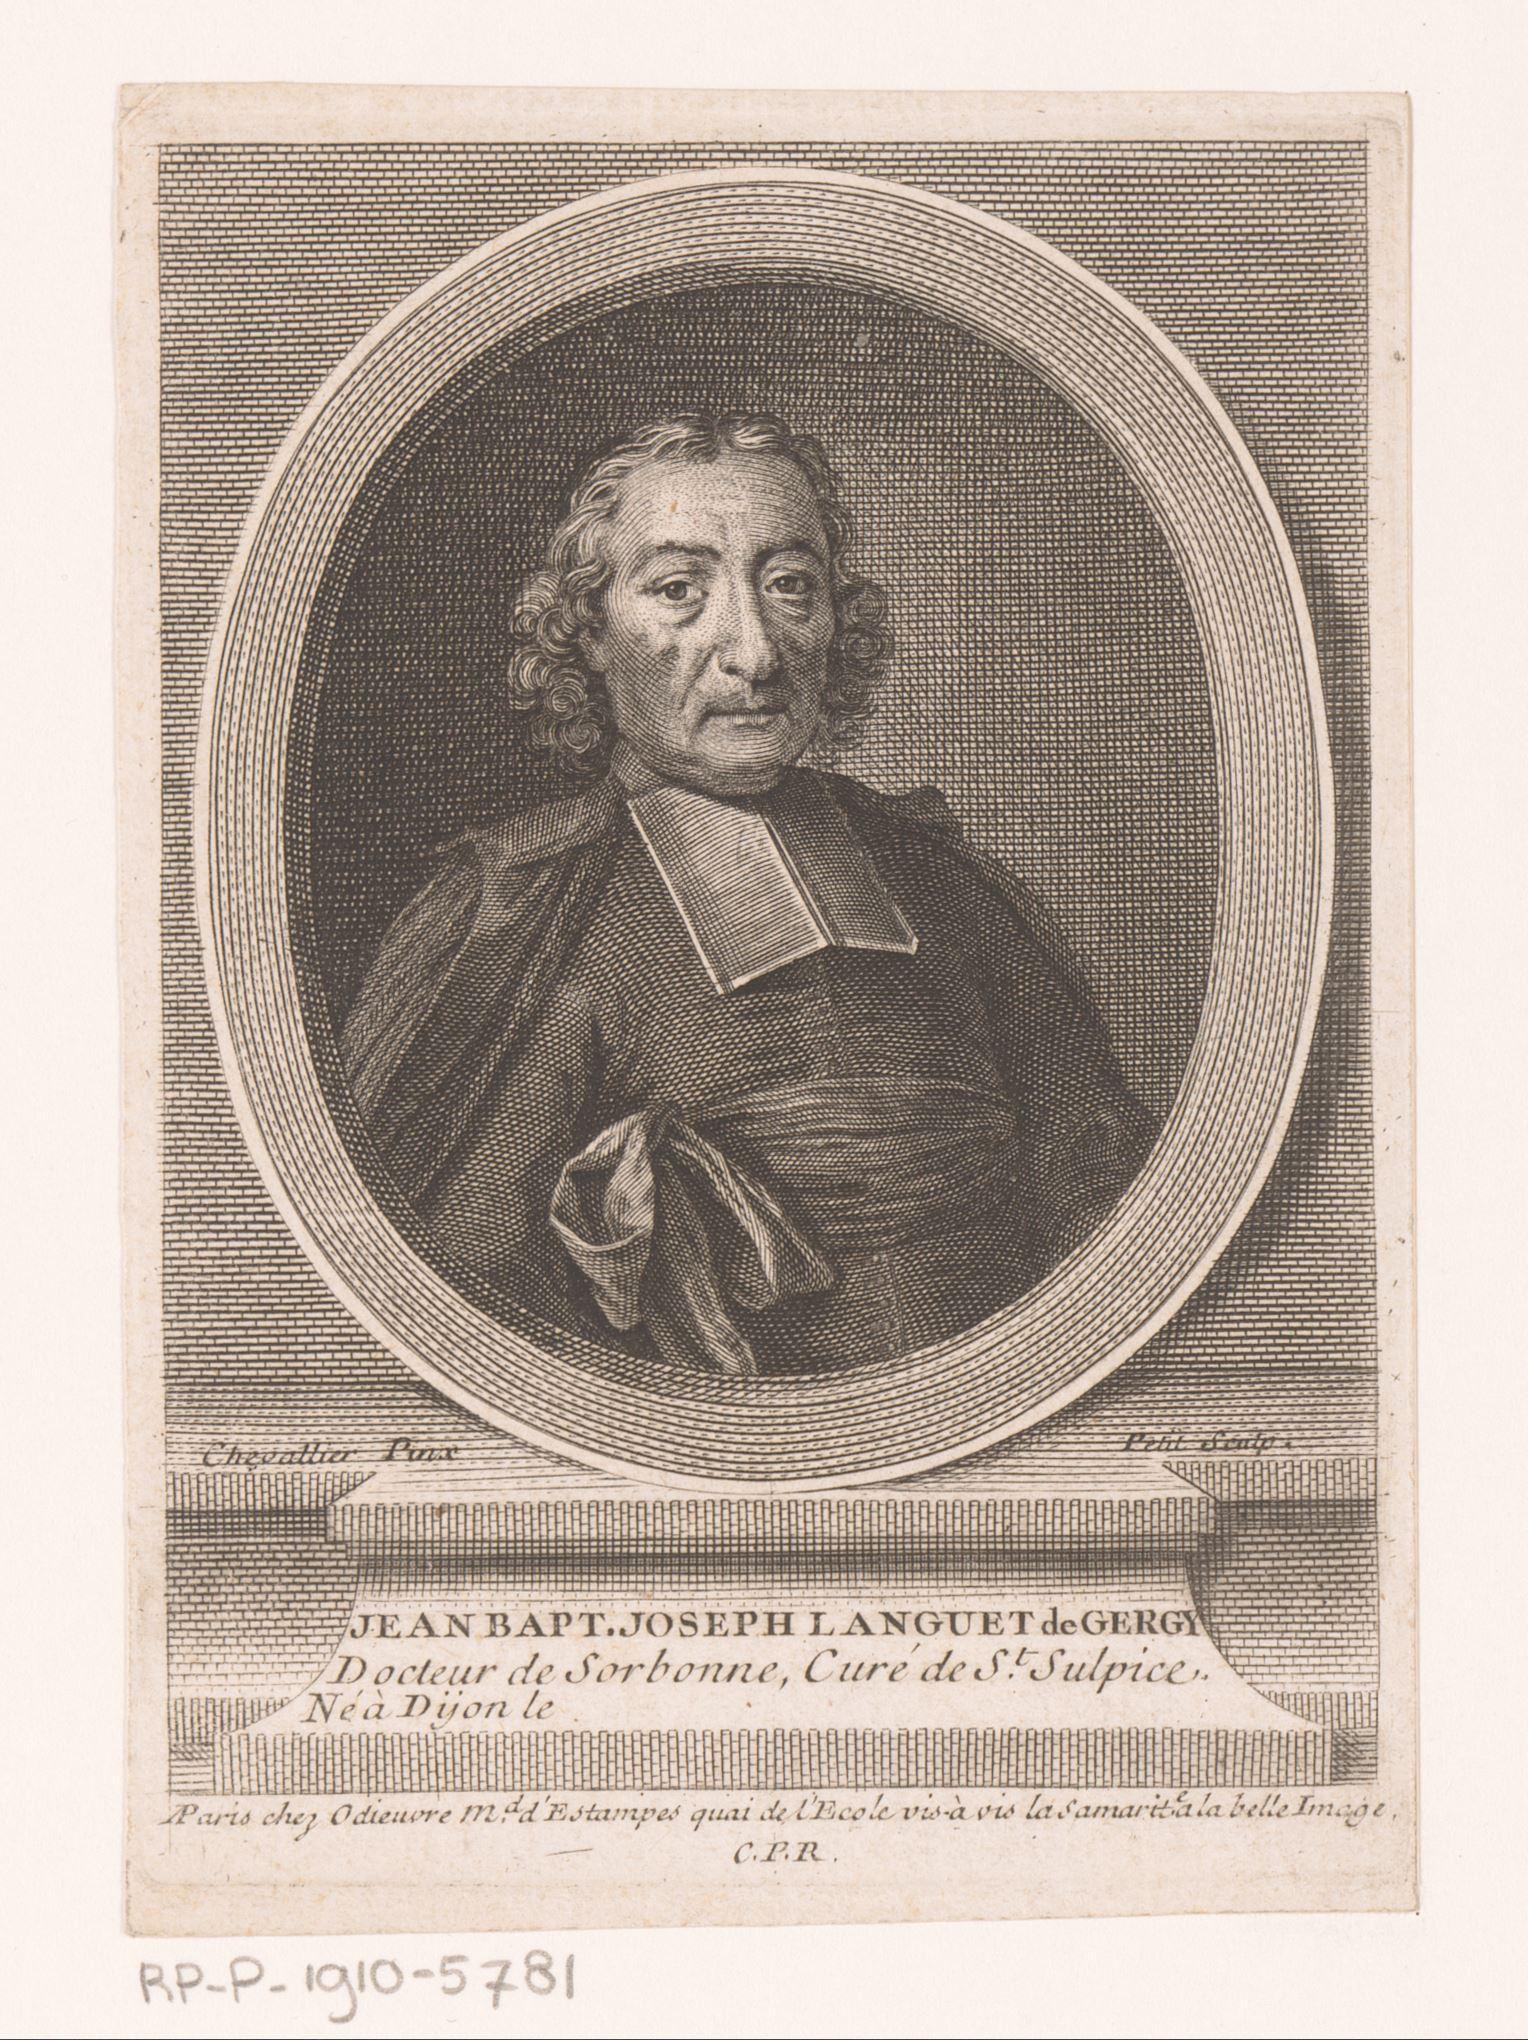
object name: book illustration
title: Portret van Jean-Baptiste-Joseph Languet de Gergy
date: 1755-1760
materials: paper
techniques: engraving, etching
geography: paris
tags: paris, priest, priest (roman catholic), historical persons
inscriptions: collector's mark: Lugt 2228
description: Prent uit: Dreux du Radier, Jean-François. L'Europe illustré, contenant l'histoire abregée des souverains, des princes, des prélats, des ministres, (...) en Europe: dans le XVe. siècle compris, jusqu'à présent. Parijs: Michel Odieuvre en André-François Le Breton, 1755-1765.